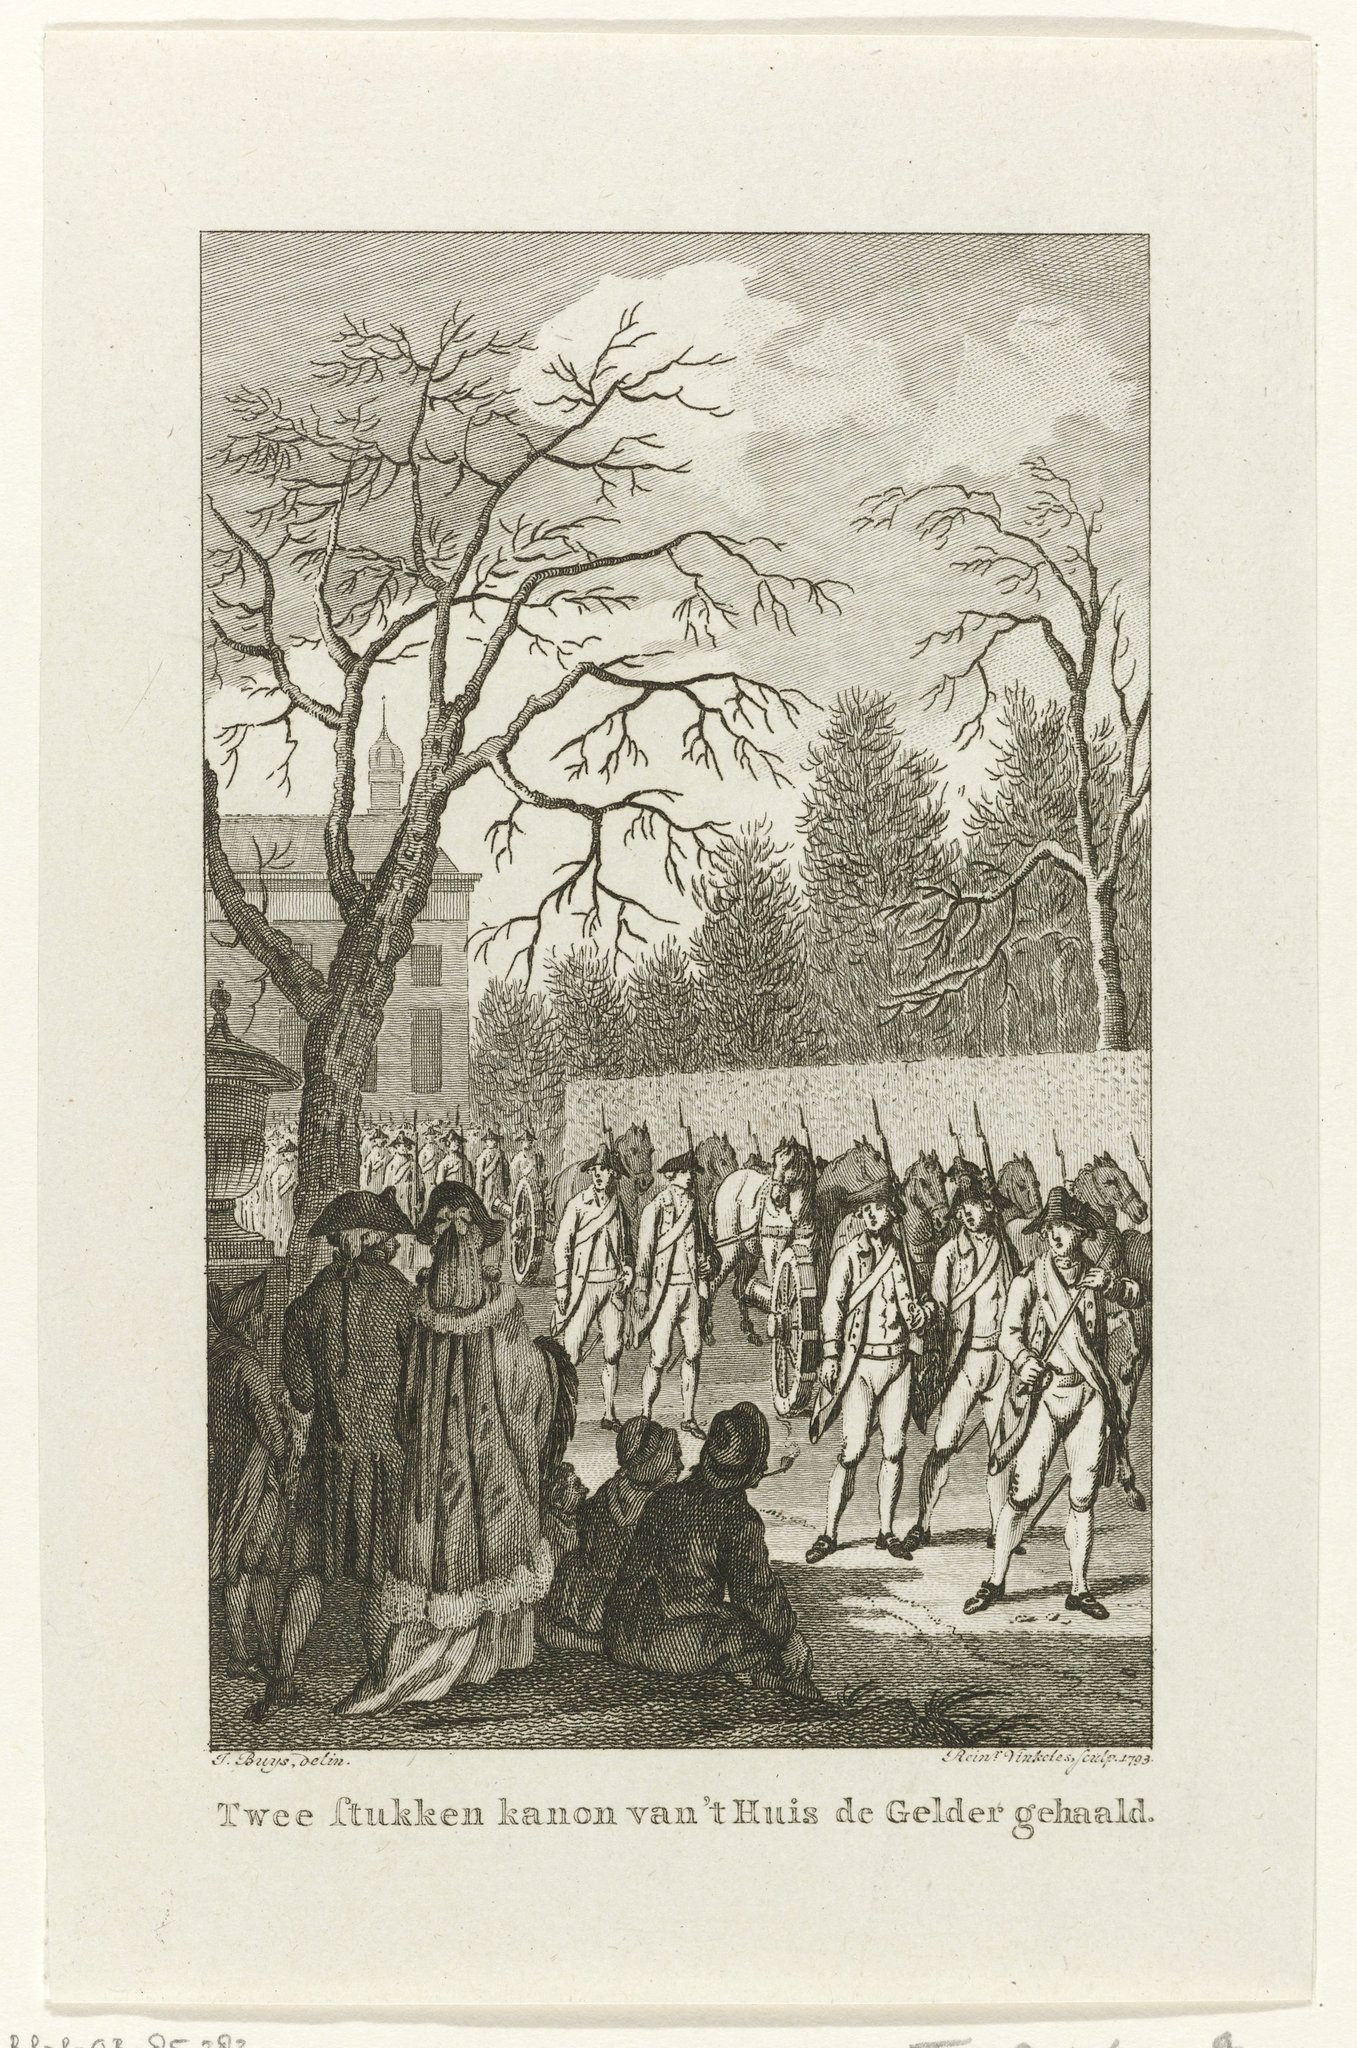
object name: print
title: Twee stukken kanon van 't Huis de Gelder gehaald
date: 1793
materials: paper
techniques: engraving, etching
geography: northern netherlands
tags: wijhe, warfare; military affairs (+ citizen soldiery, civil guard, citizen militia), deventer, patriots (1780-1795)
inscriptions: collector's mark: Lugt 2228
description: De leden van de vrijkorps van Deventer, aan wie de twee kanonnen door jhr. Frederik Gijsbert van Dedem tot den Gelder geschonken zijn, halen plechtig de stukken geschut op uit het Huis de Gelder te Wijhe, 31 januari 1785.